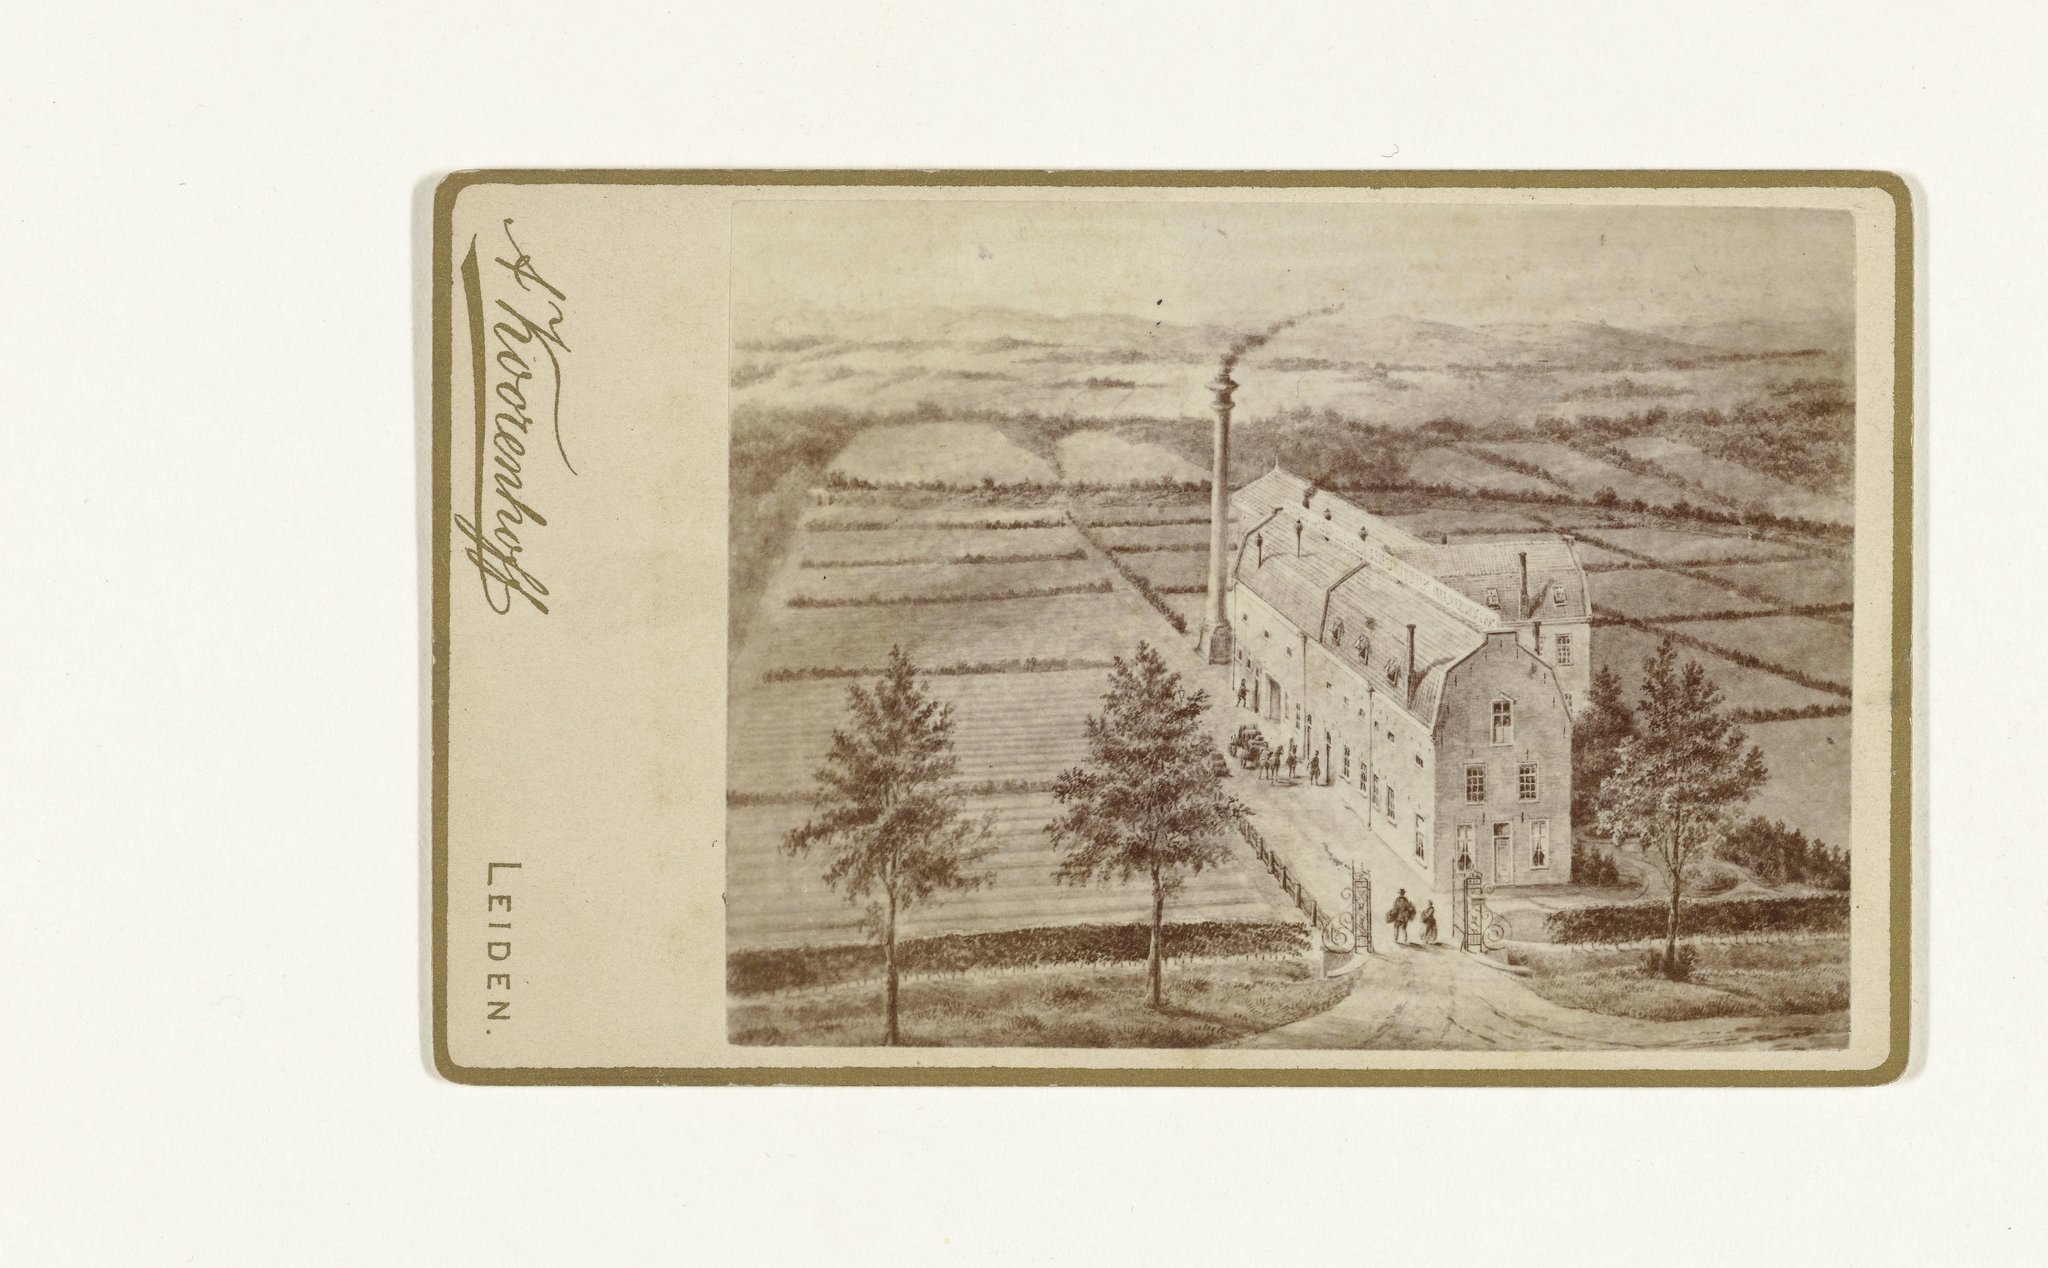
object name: photograph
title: Fotoreproductie van een tekening of prent van fabriek Anna in Noordwijk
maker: abraham koorenhoff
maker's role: fotograaf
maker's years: 1844-1917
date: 1865-1890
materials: cardboard, paper, photographic support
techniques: albumen print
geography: leiden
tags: factory in landscape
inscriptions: inscription: ‘A Koorenhoff / Photographe / VAN Z.M. DEN KONING DER NEDERLANDEN / TE / LEIDEN / Gerecht No 5 / by de Pieterskerk / [...] / Specialiteit in Vergroote Portretten enz. / 1887. / [...]’, annotation: ‘Fabriek van verduurzaamde / levensmiddelen "Anna" / te Noordwijk Binnen van / den Heer W.A. Blokhuis’, inscription: ‘A Koorenhoff LEIDEN’